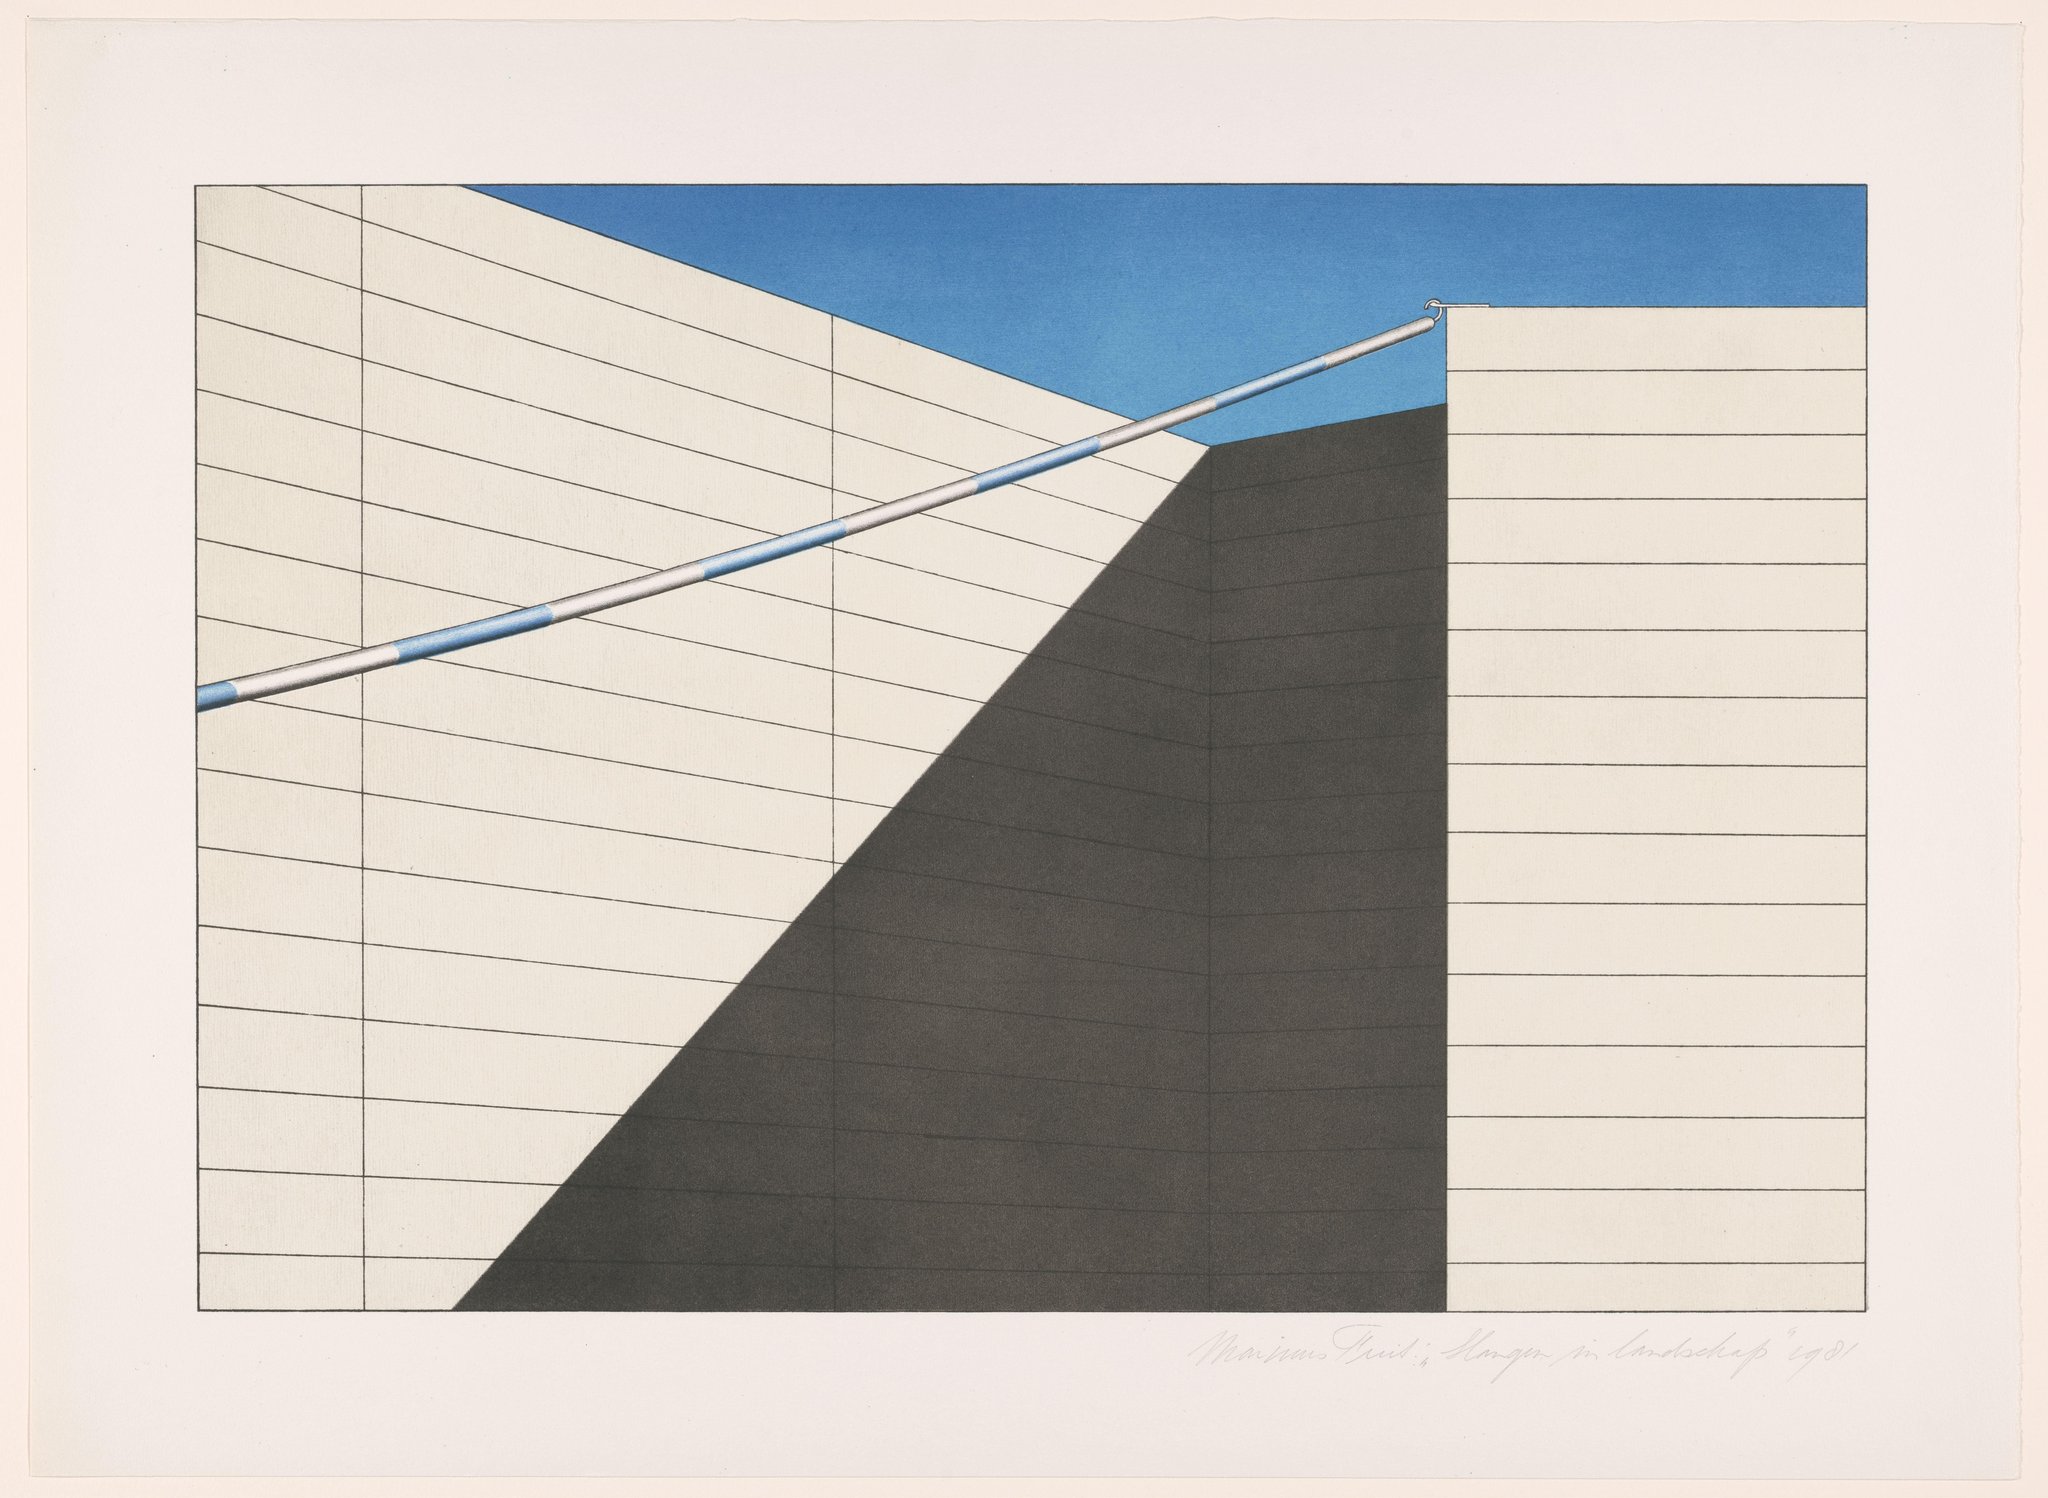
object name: print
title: Slangen in landschap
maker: marinus fuit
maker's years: 1934-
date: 1981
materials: paper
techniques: lithograph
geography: netherlands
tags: snakes, landscapes, receiver, fence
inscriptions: collector's mark: Lugt 2228, inscription: ‘voor Piet’, inscription: ‘PC’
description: Hoge witte schutting met een blauw met witte balk.